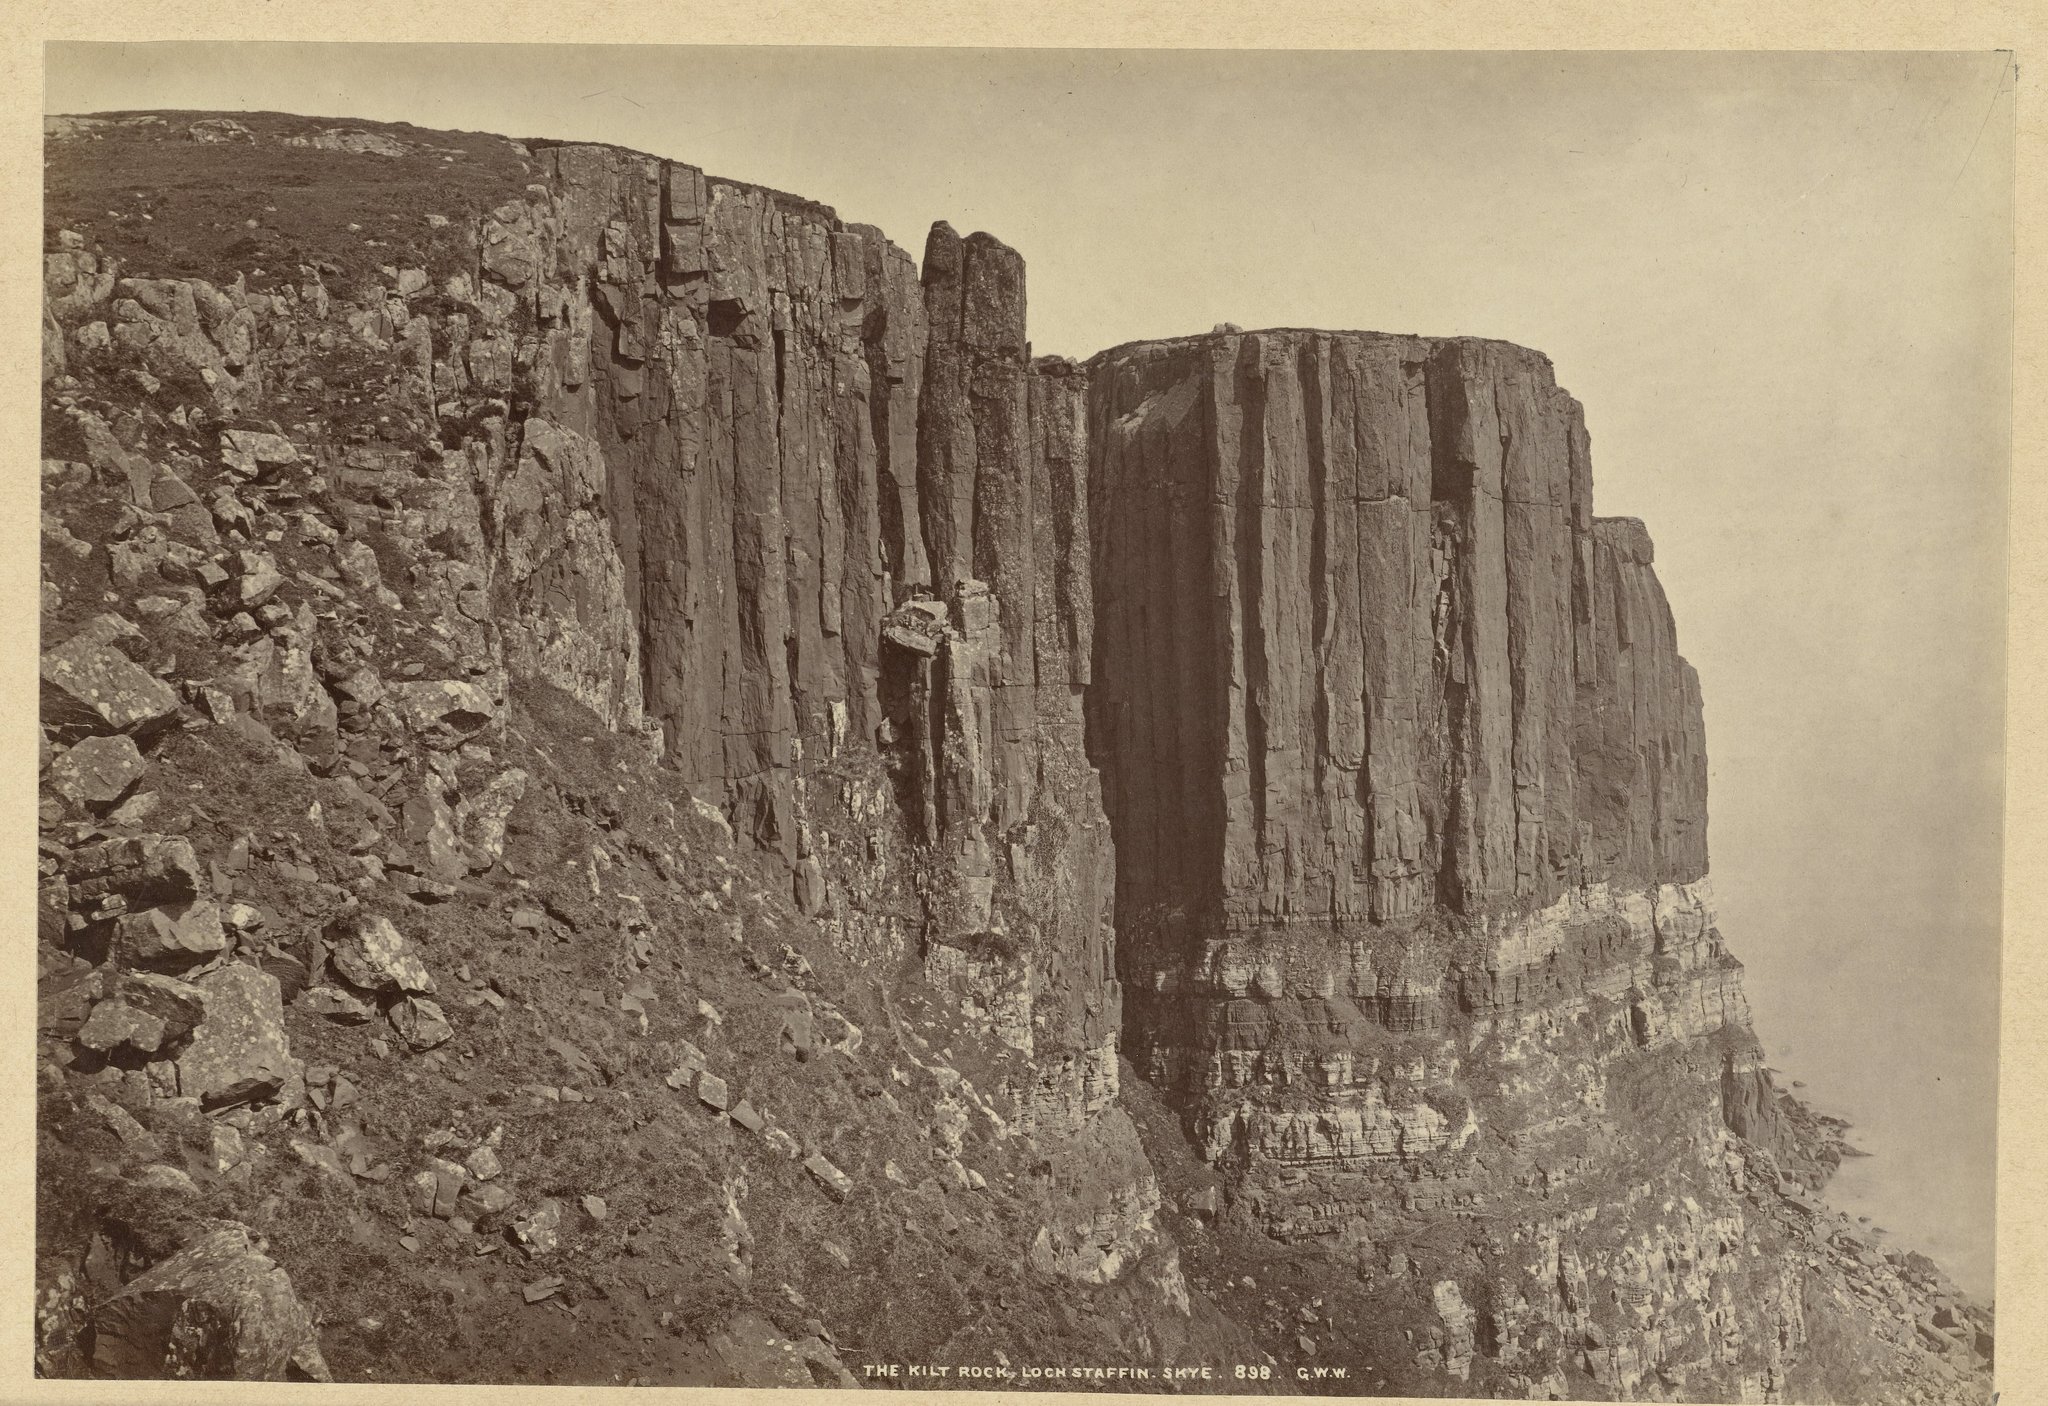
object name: photograph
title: Kilt Rock op Skye, Schotland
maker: george washington wilson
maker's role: publisher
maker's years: 1823-1893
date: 1860-1880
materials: cardboard, paper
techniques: albumen print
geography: skye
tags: coastal cliff or crag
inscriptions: inscription: ‘George Washington Wilson/ +- 1870's 60,=’, number: ‘898.’